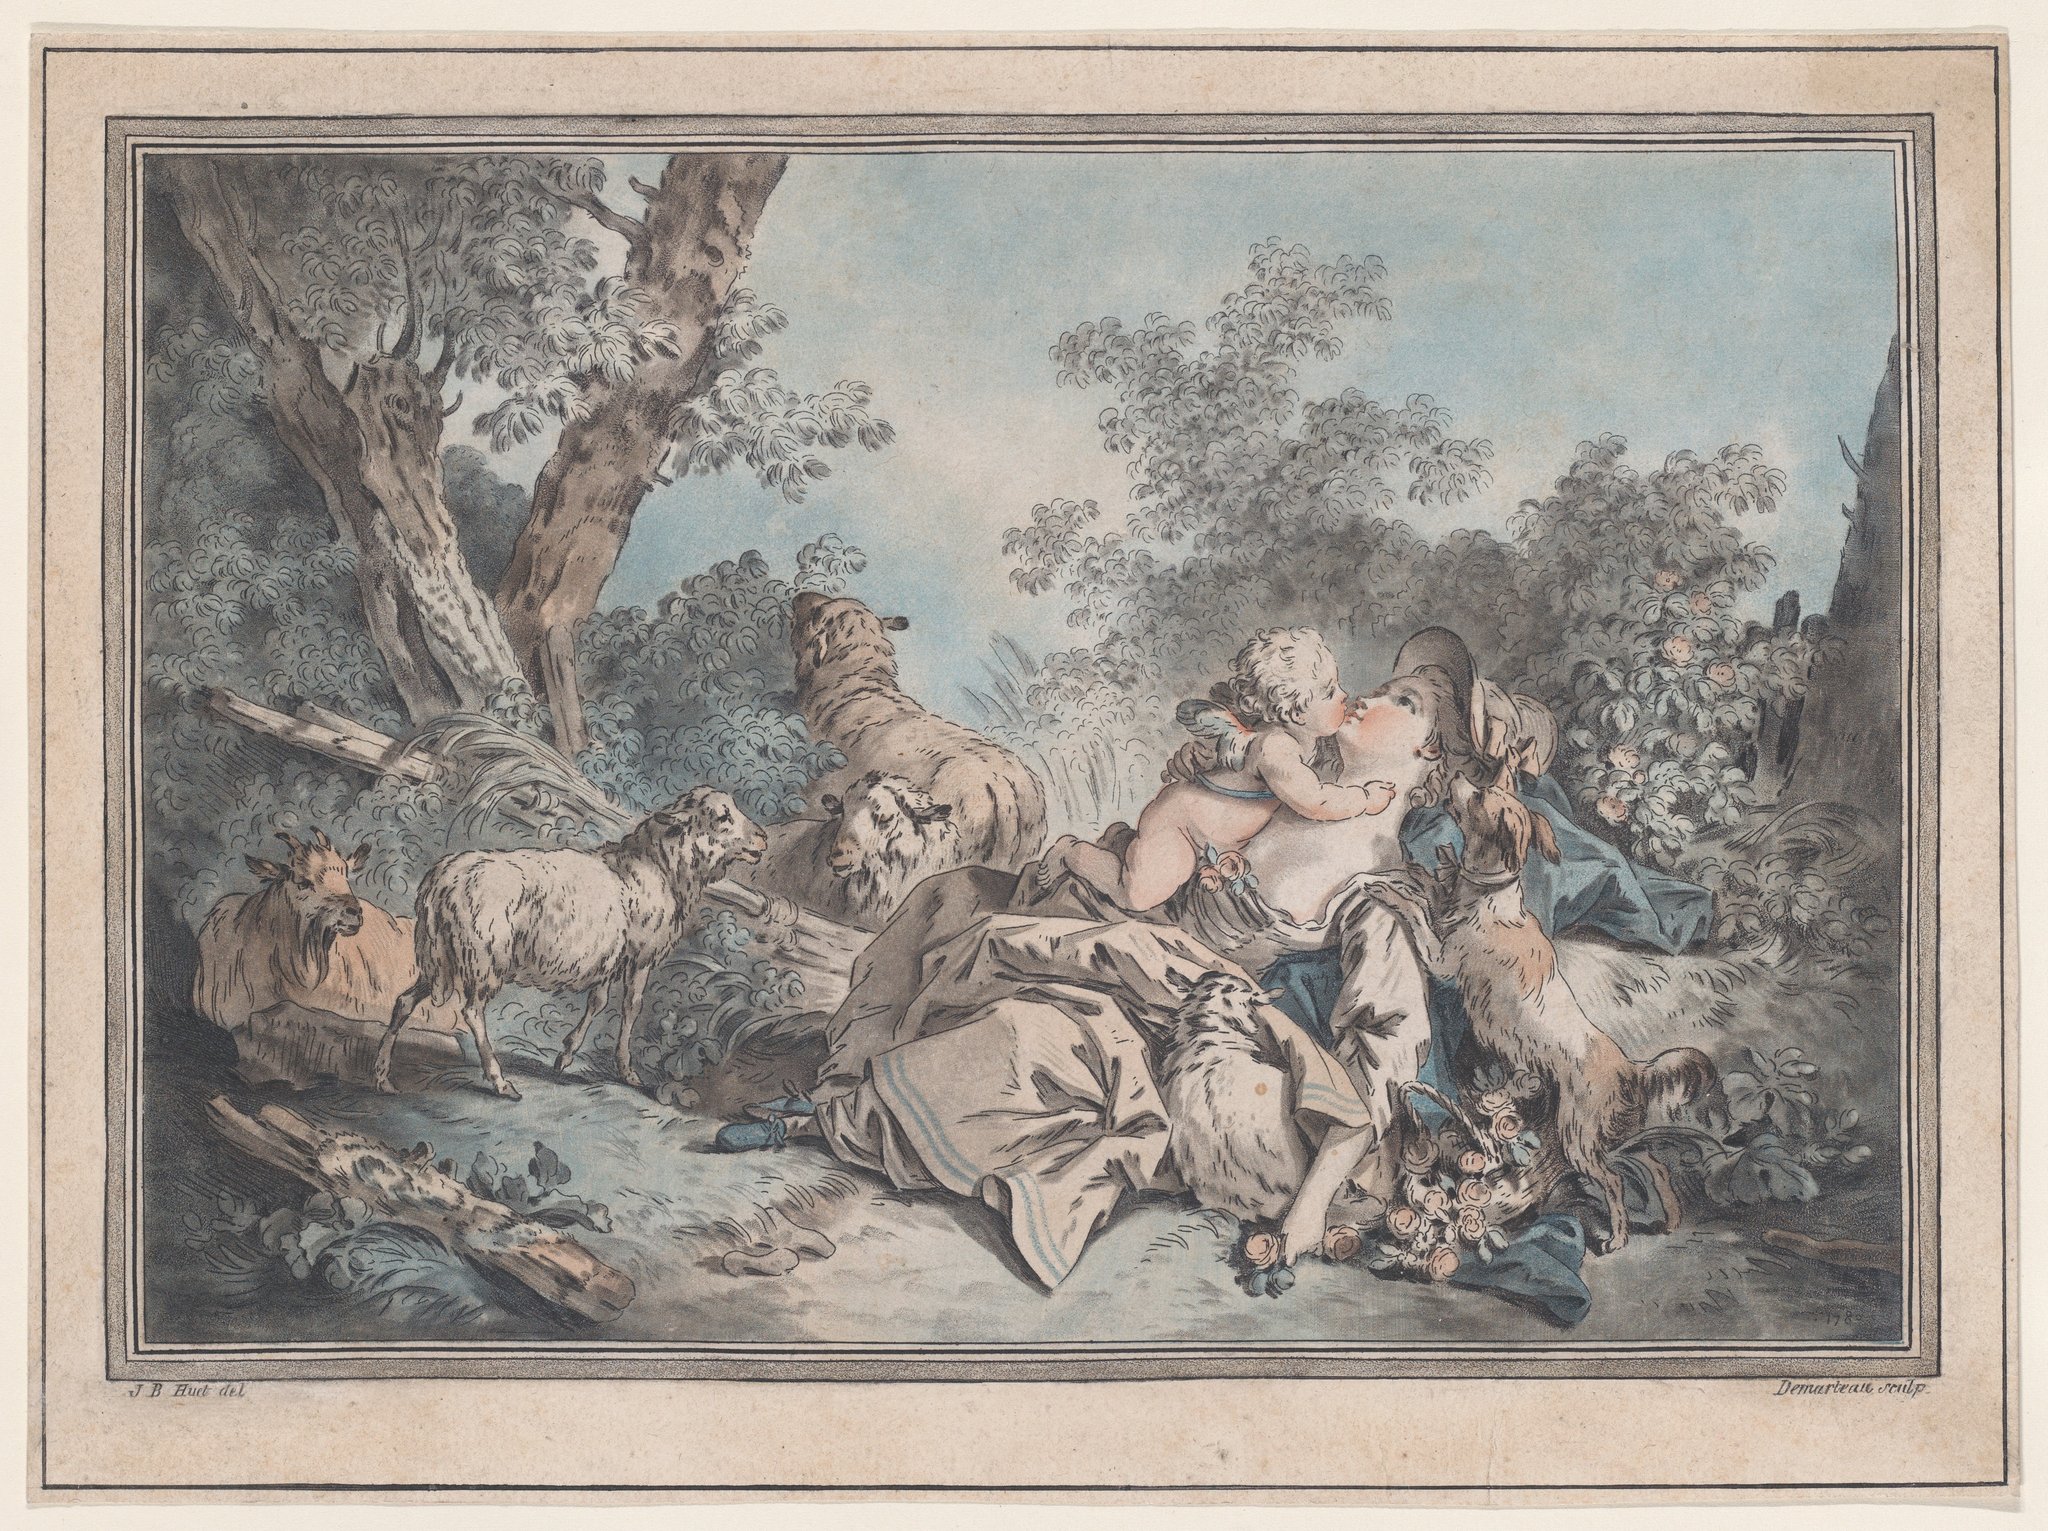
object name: print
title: Shepherdess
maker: gilles-antoine demarteau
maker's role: artist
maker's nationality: french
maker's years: 1756-1802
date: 1780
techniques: aquatint, etching, roulette, engraving